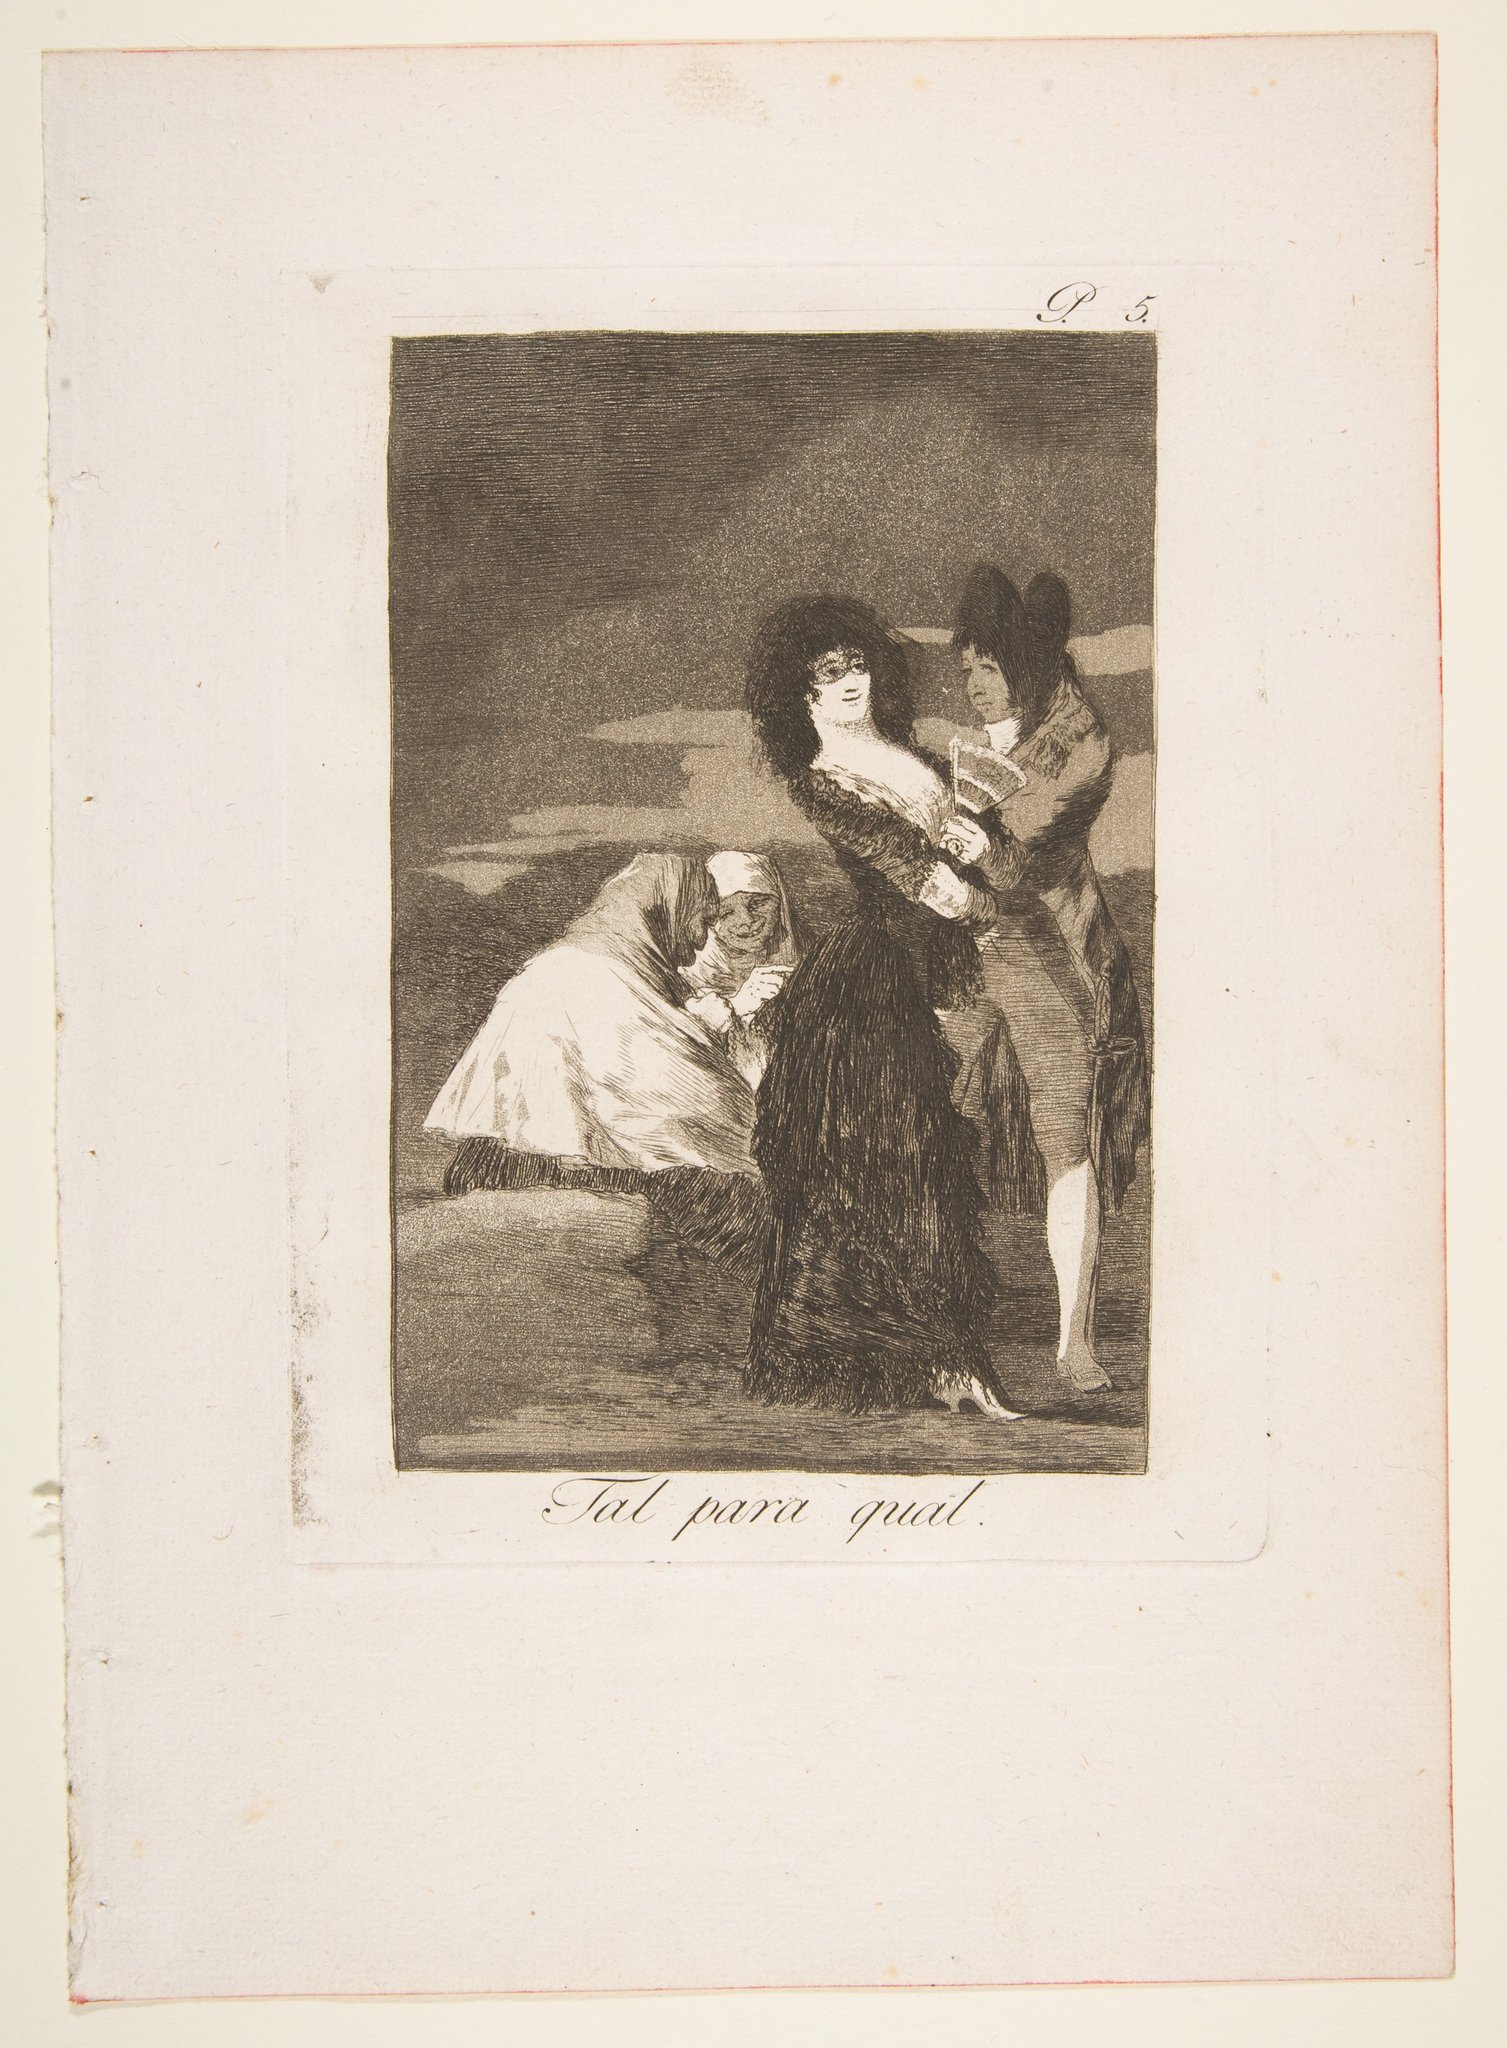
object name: print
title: Plate 5 from "Los Caprichos": Two of a kind (Tal para qual)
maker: goya (francisco de goya y lucientes)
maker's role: artist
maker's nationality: spanish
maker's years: 1746-1828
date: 1799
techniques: aquatint, drypoint, etching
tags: men,women